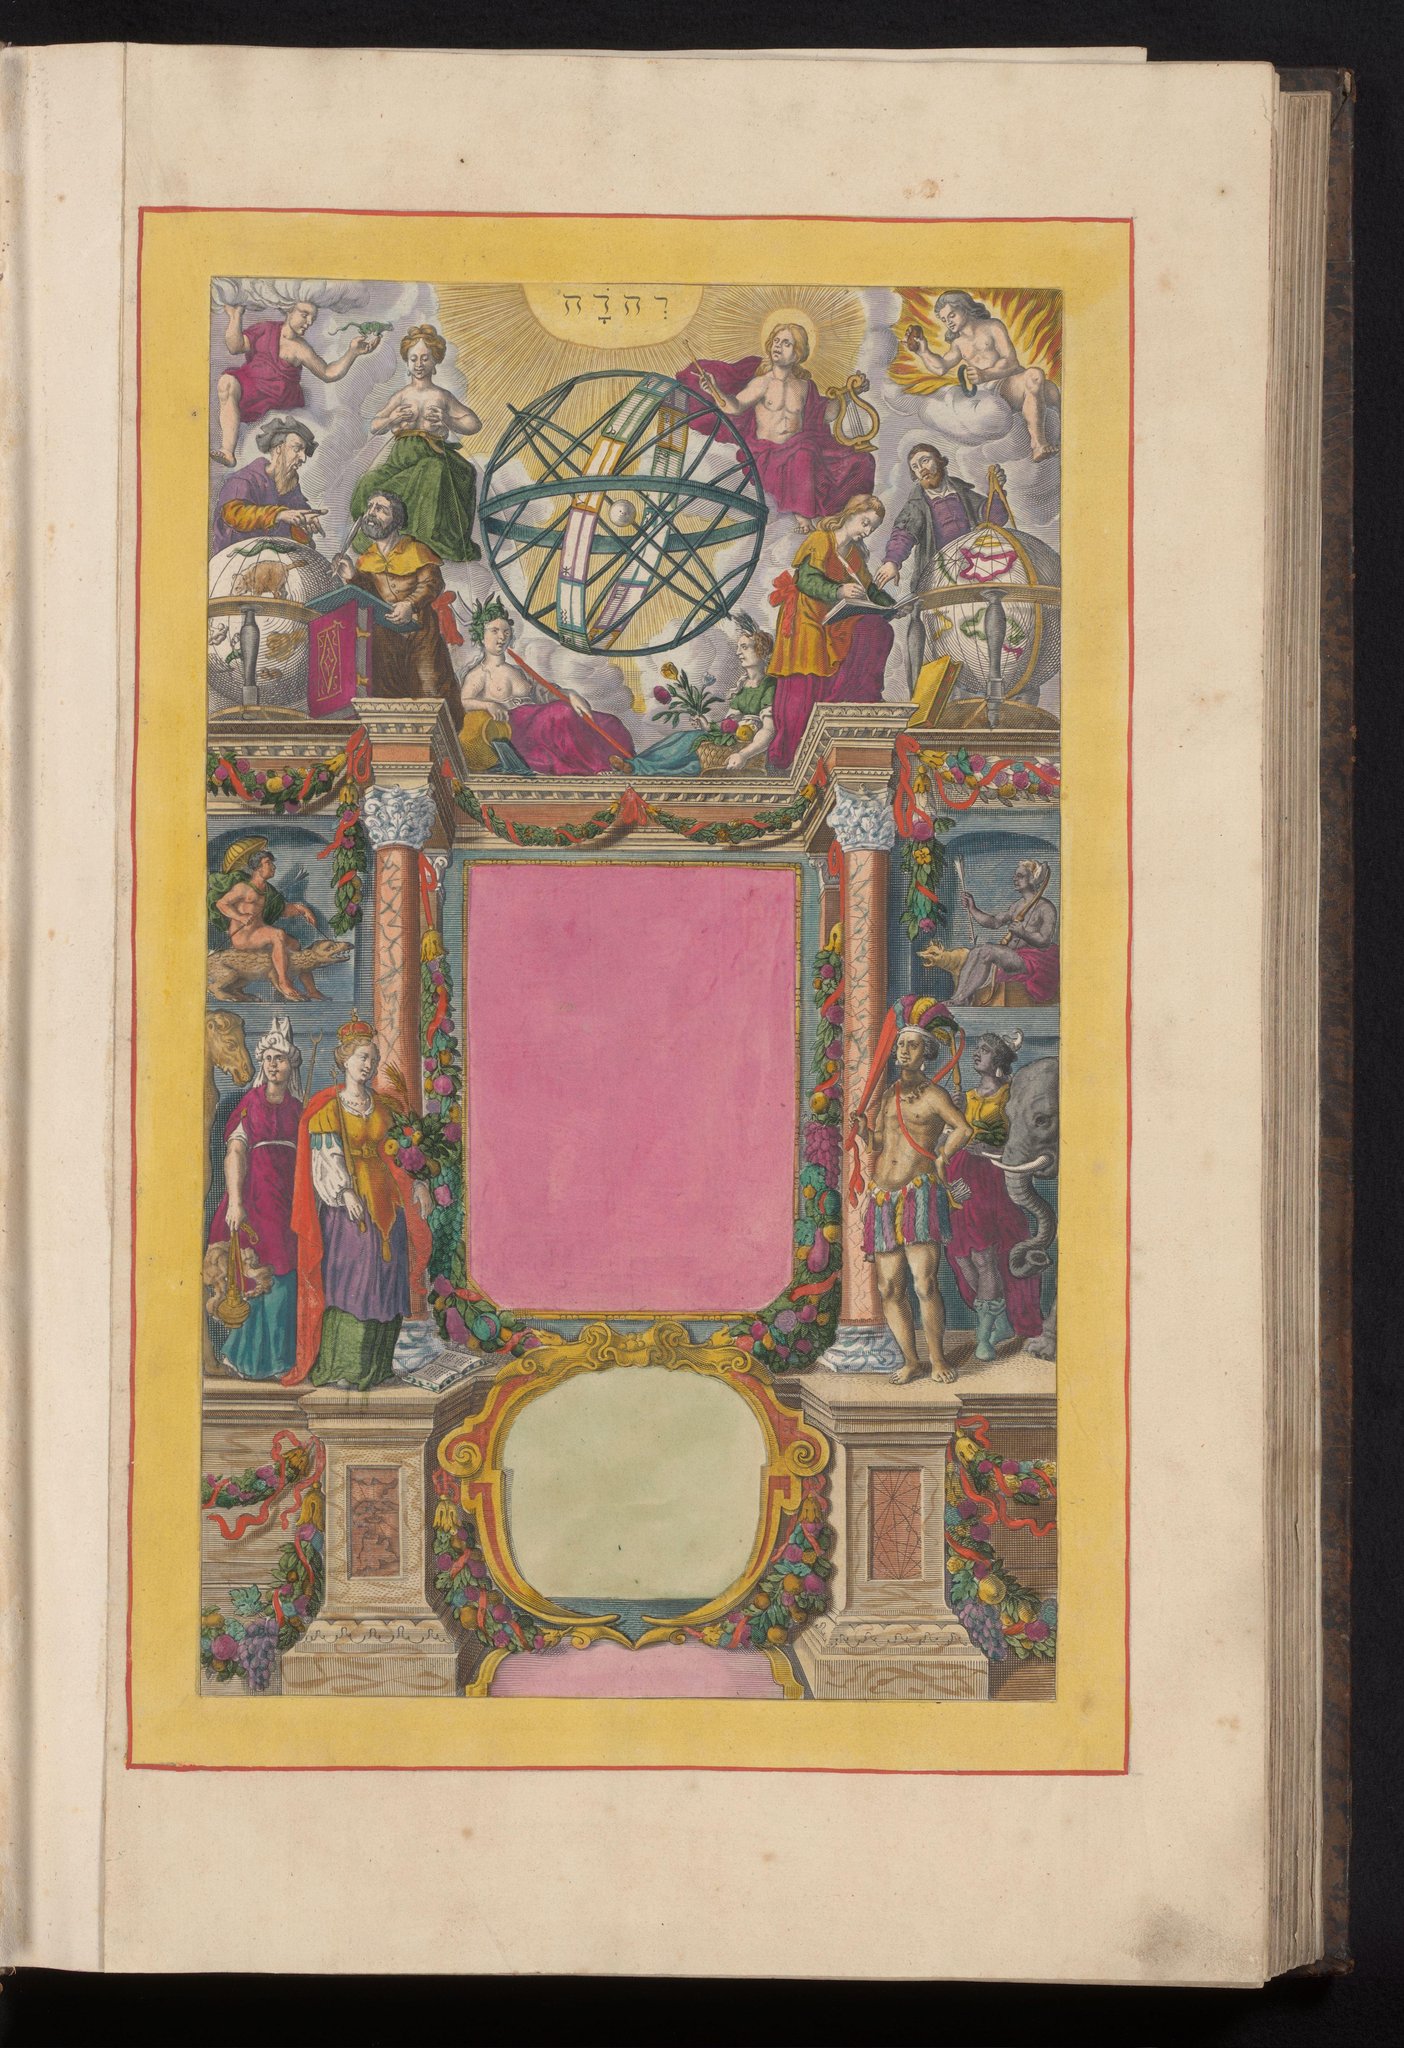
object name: titelblad, titelpagina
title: Cartouche geflankeerd door de personificaties van de vier werelddelen en bekroond door een hemelglobe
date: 1630-1717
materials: paper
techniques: engraving, etching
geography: netherlands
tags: the four elements, and ether, the fifth element, (story of) apollo (phoebus), ornament ~ cartouche, armillary sphere, skeleton celestial globe, map making, continents represented allegorically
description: Leeg cartouche geflankeerd door de personificaties van de vier werelddelen. Links Azië als vrouw met tulband en wierookvat en Europa als koningin met scepter en hoorn des overvloeds. Rechts Amerika als indaan en Afrika als zwarte vrouw met olifant. Bovenaan een hemelglobe of armillarium. Apollo troont op de wolken. In de bovenhoeken de elementen Lucht en Vuur. Onder de hemelglobe zitten de elementen Water en Aarde. Links twee geleerden die een hemelglobe met sterrenbeelden bestuderen. Rechts een man die metingen verricht op een wereldglobe en een vrouw die de metingen optekent. Prent maakt deel uit van een album.